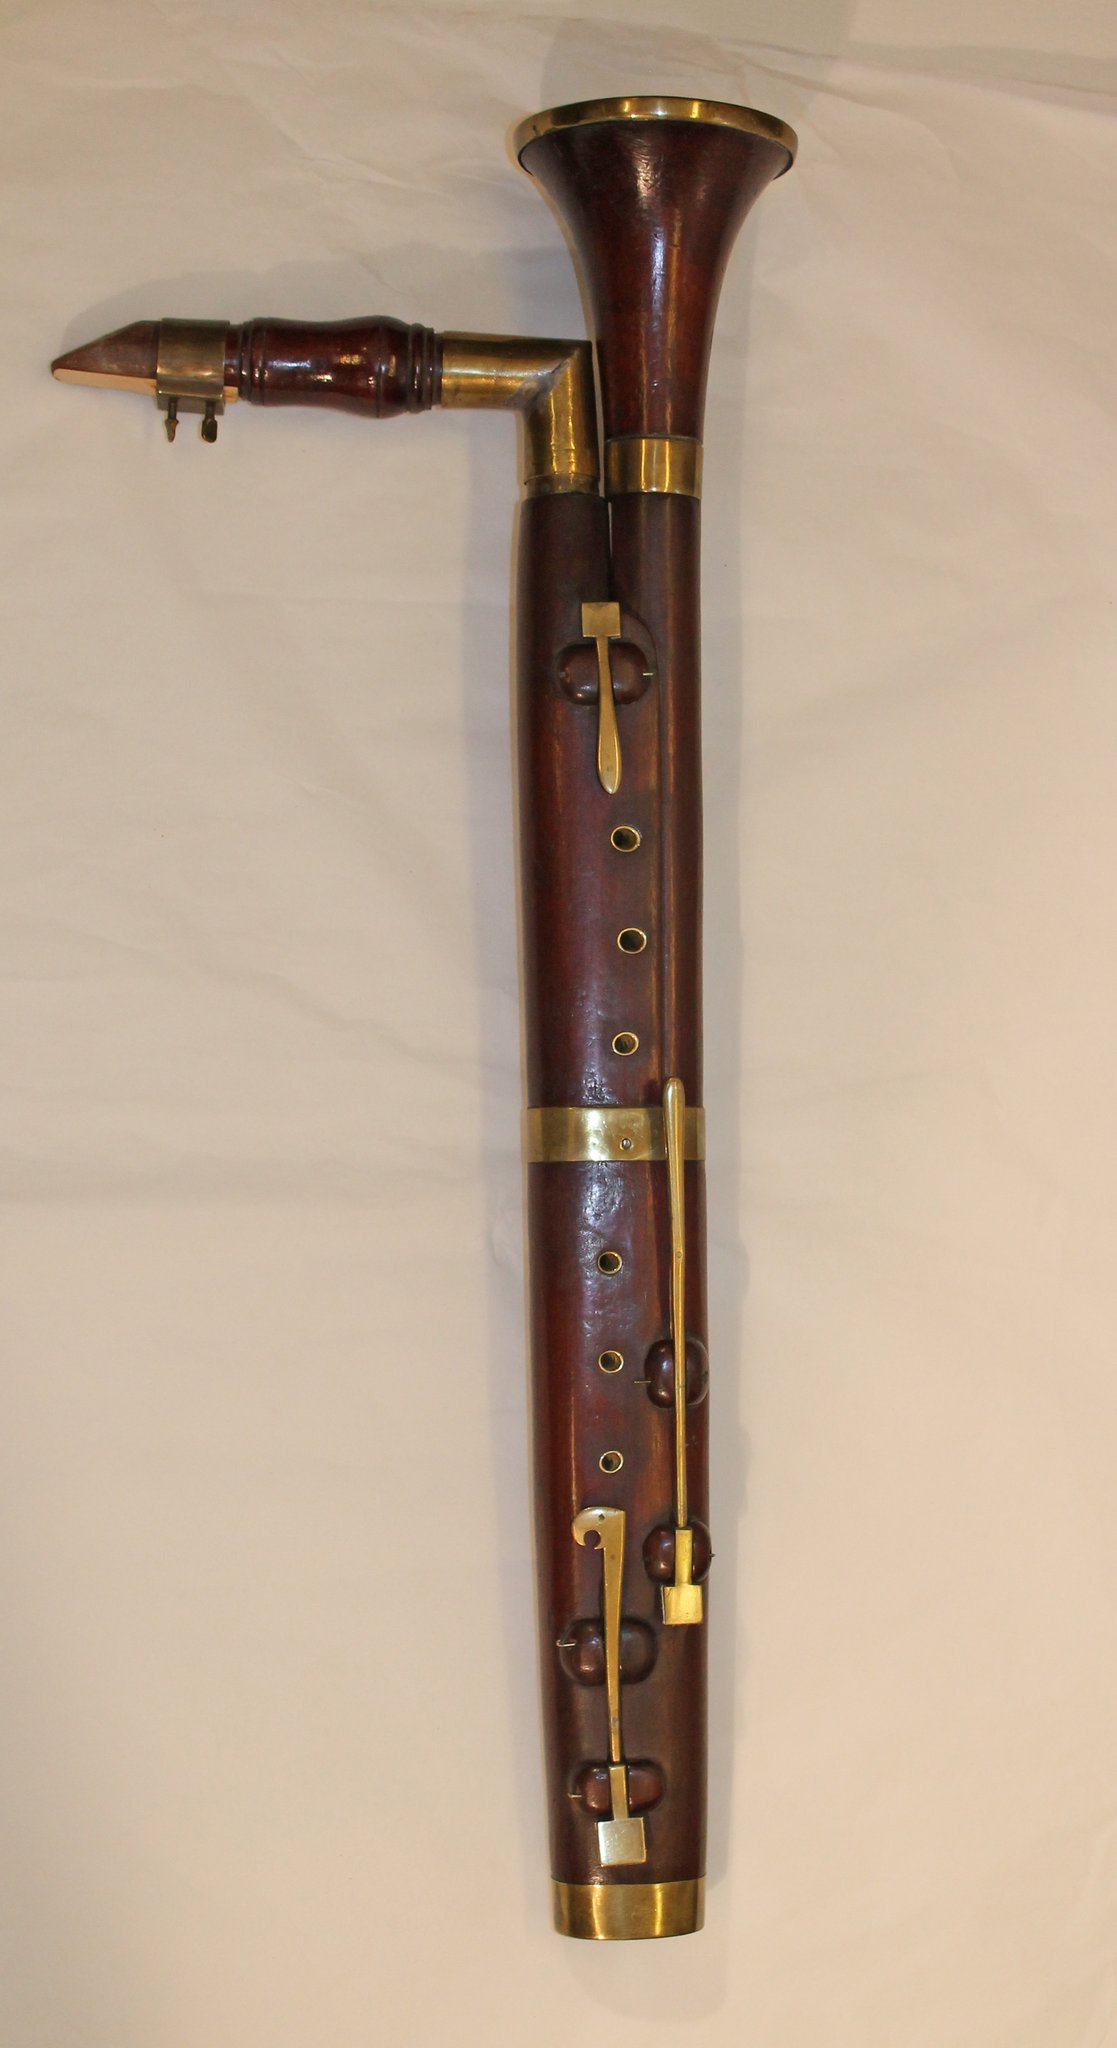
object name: clarion in e flat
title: Clarion in E-flat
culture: american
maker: george catlin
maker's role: maker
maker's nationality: american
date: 1820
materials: metal, wood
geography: united states